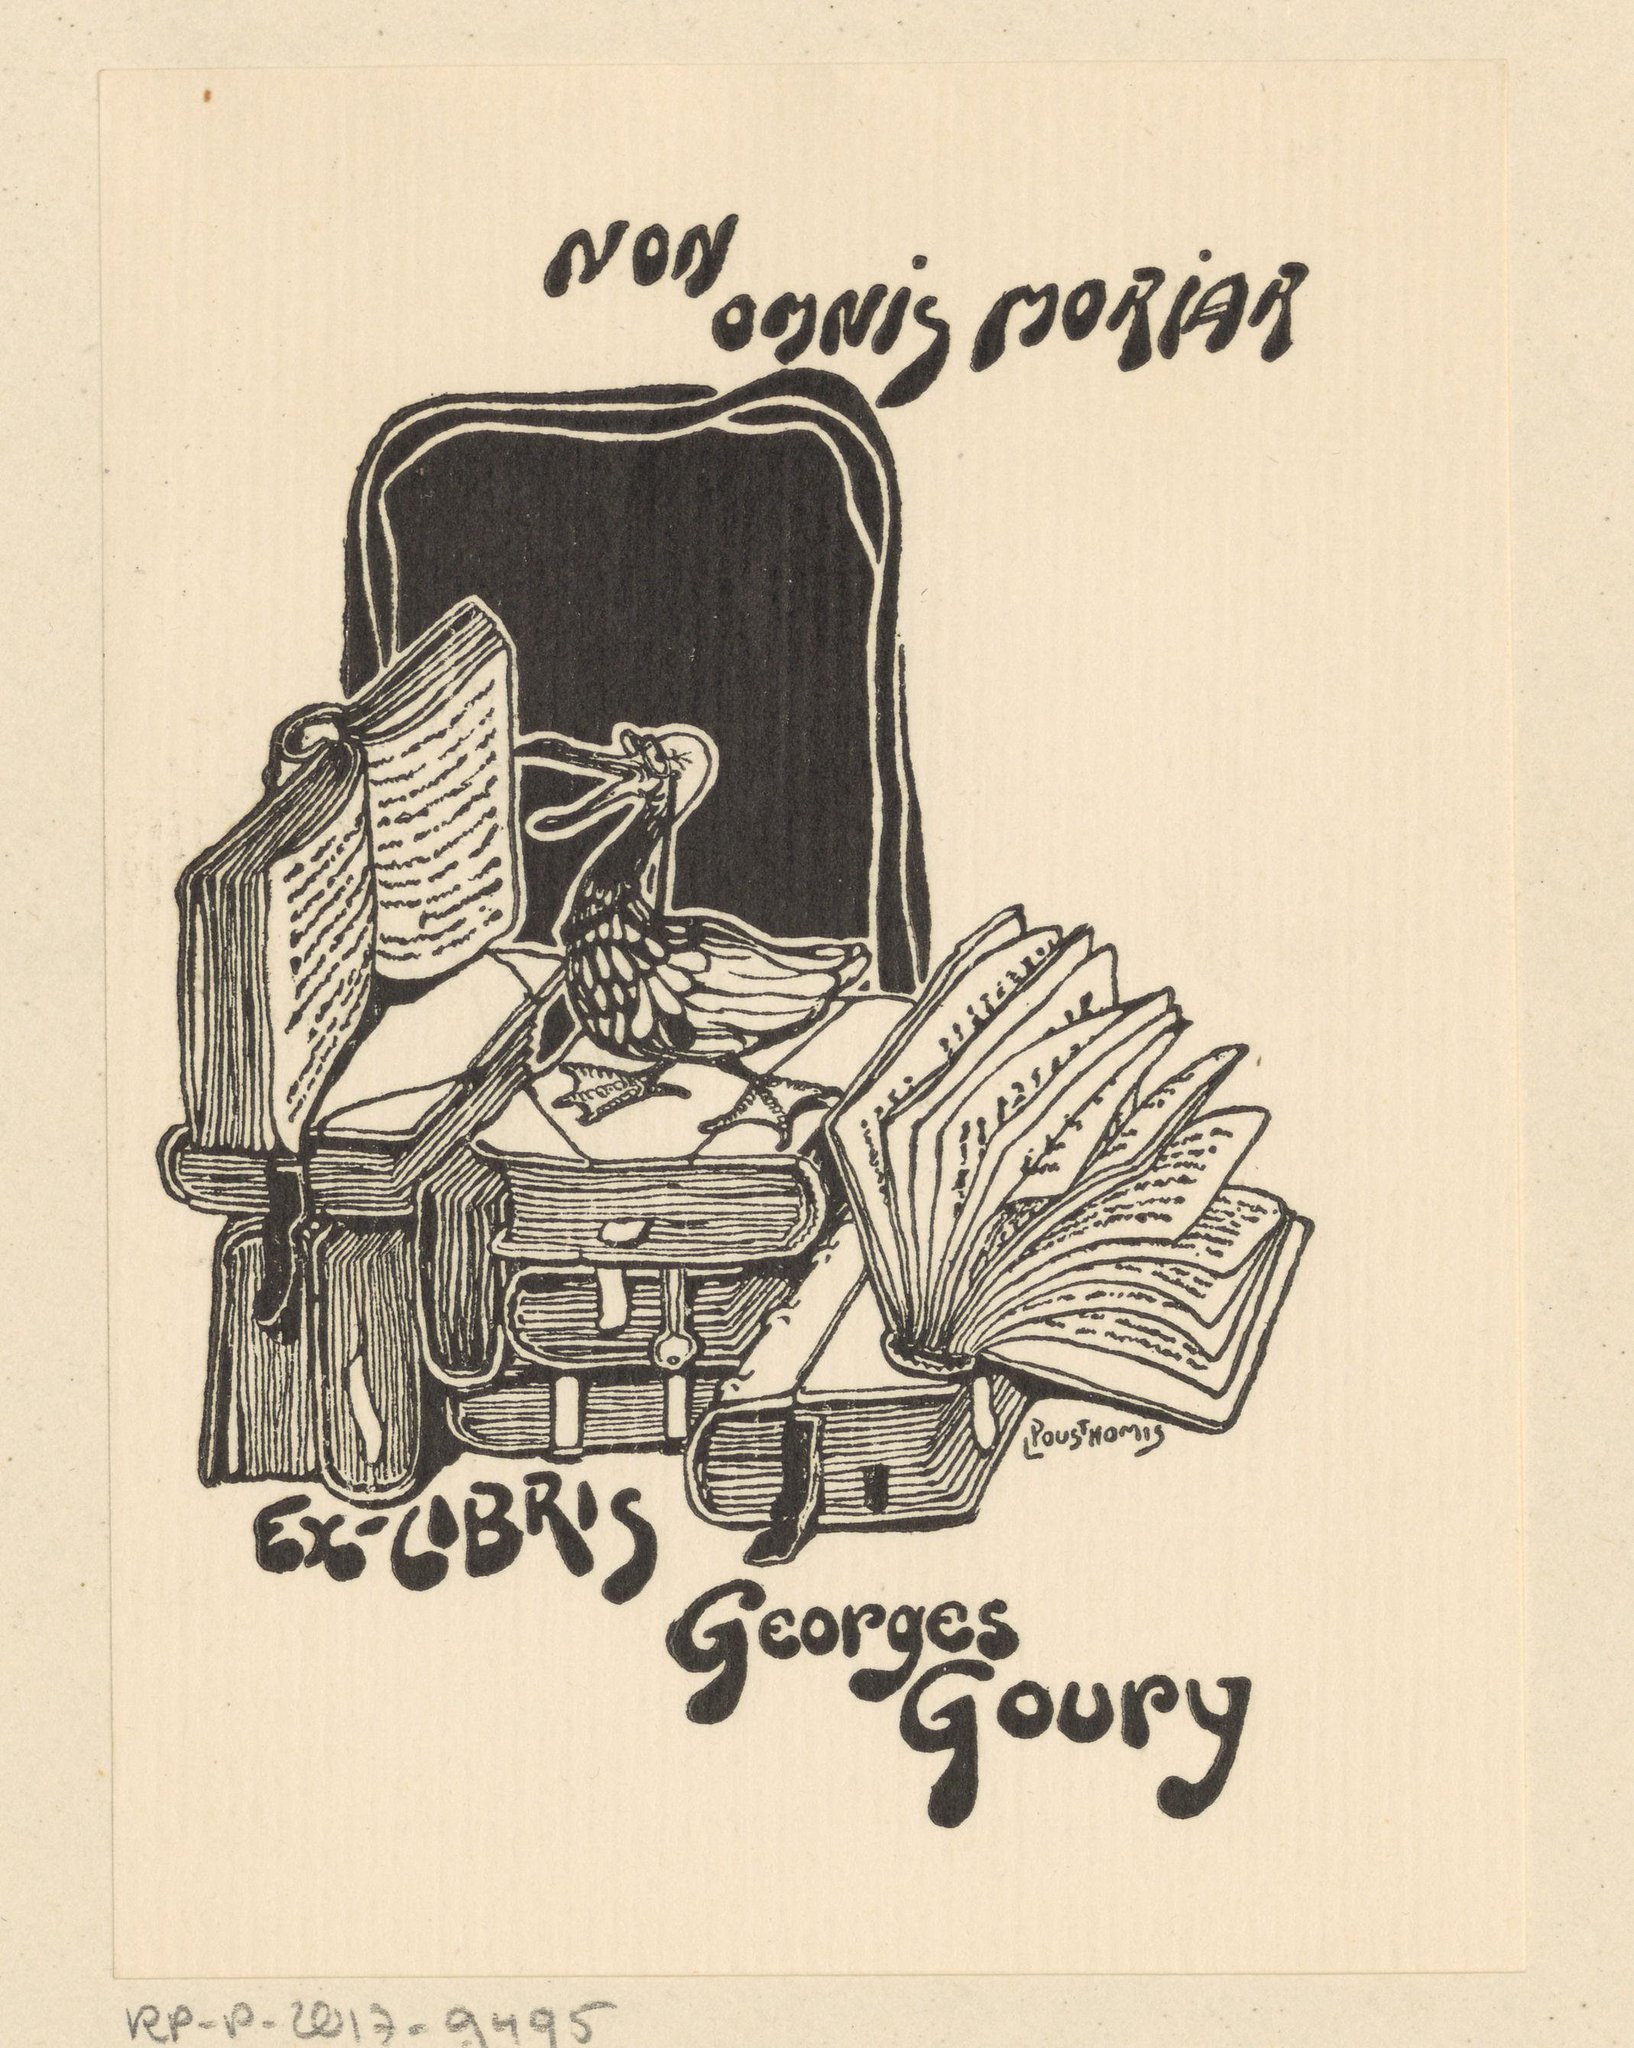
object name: bookplate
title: Ex libris van Georges Goury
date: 1891-1916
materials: paper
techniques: printing block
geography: france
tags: reading, book, water-birds: duck